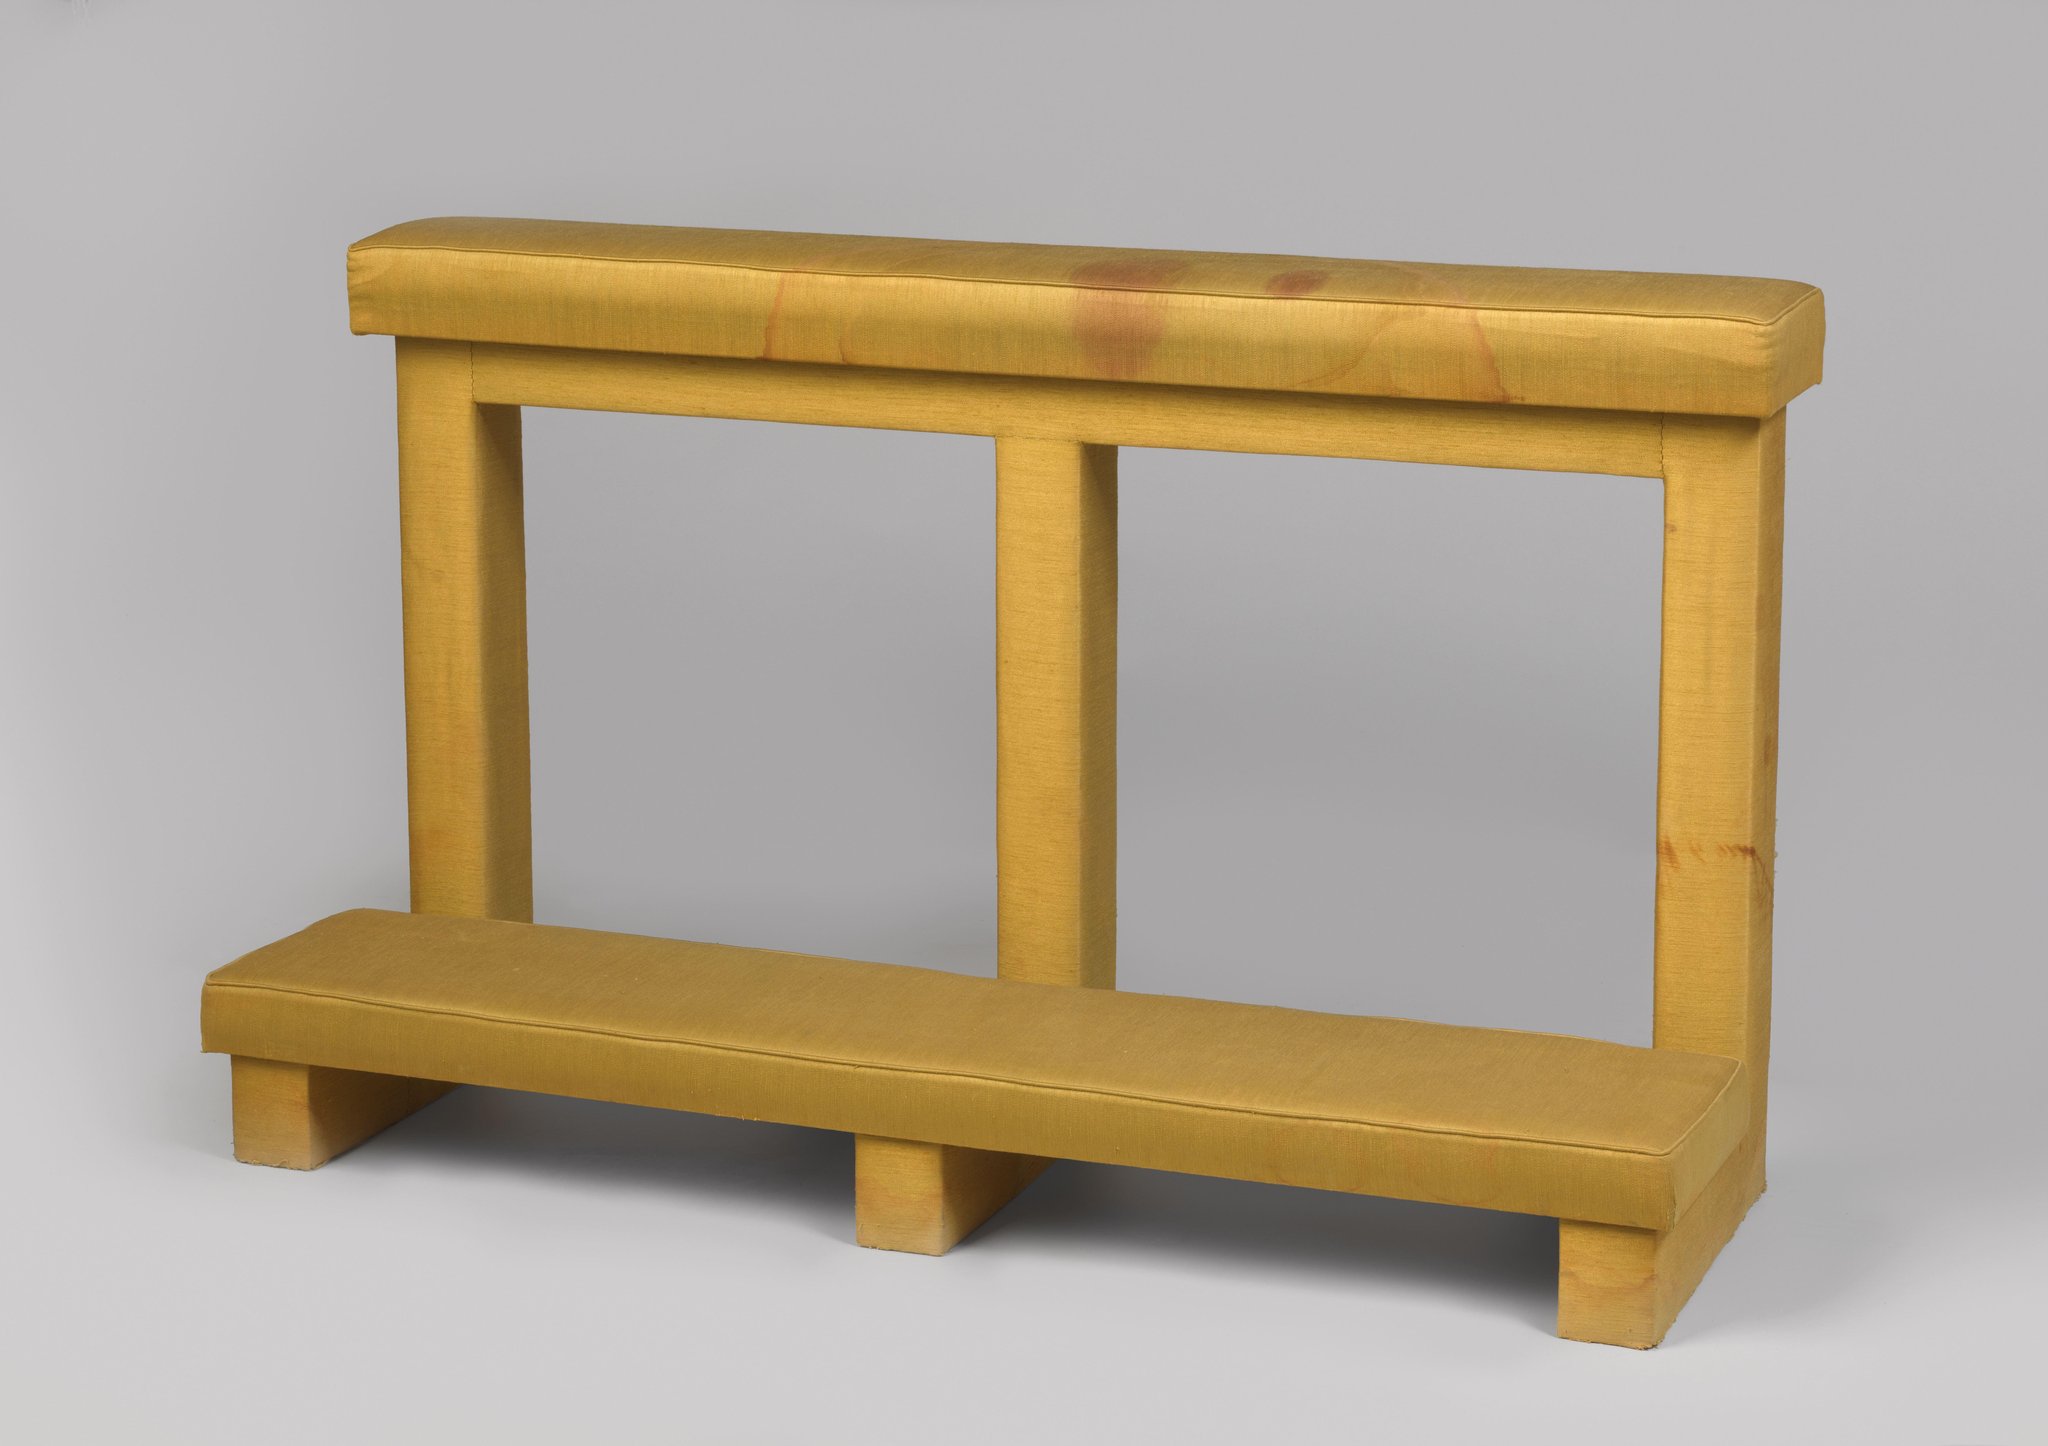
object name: kerkmeubel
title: Knielbank van de trouwplechtigheid van prinses Beatrix van Oranje-Nassau en Claus von Amsberg in de Westerkerk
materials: wood, textile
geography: amsterdam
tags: amsterdam, beatrix (koningin der nederlanden)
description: Houten knielbank, gestoffeerd met groen-geel textiel.